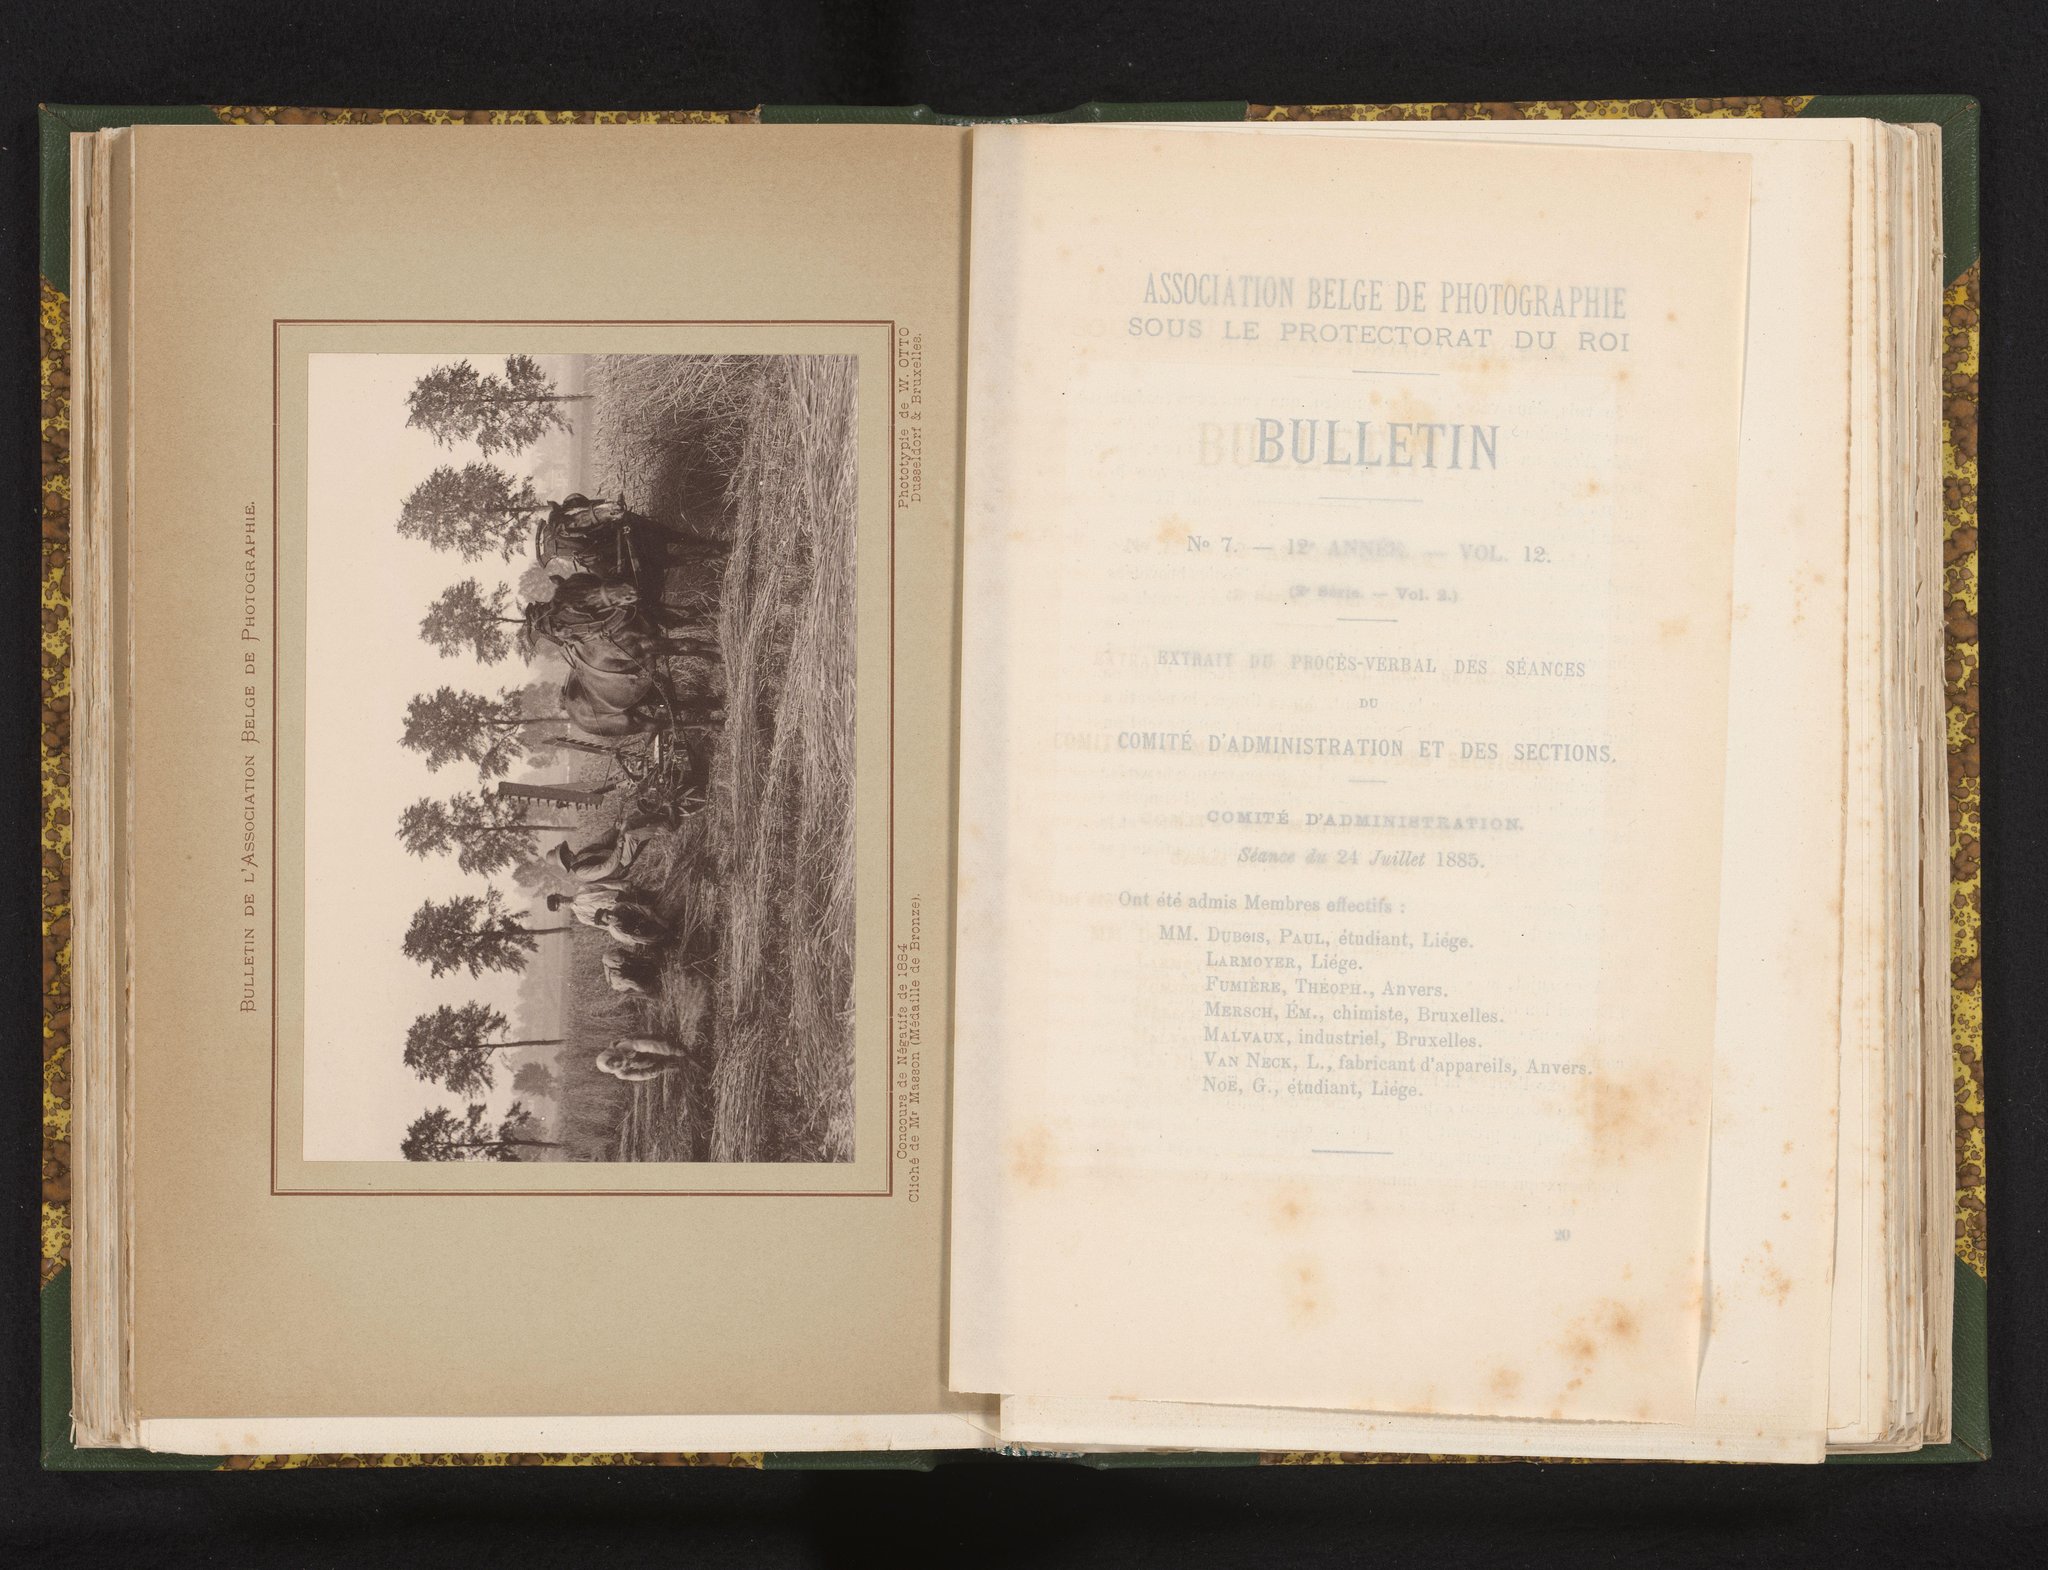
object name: page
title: Hooiende boeren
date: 1879-1884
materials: cardboard, paper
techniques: photograph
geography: brussels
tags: agricultural products and by-products: hay, farmers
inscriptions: inscription: ‘Concours de Négatifs de 1884/ Cliché de Mr Masson (Médaille de Bronze).’